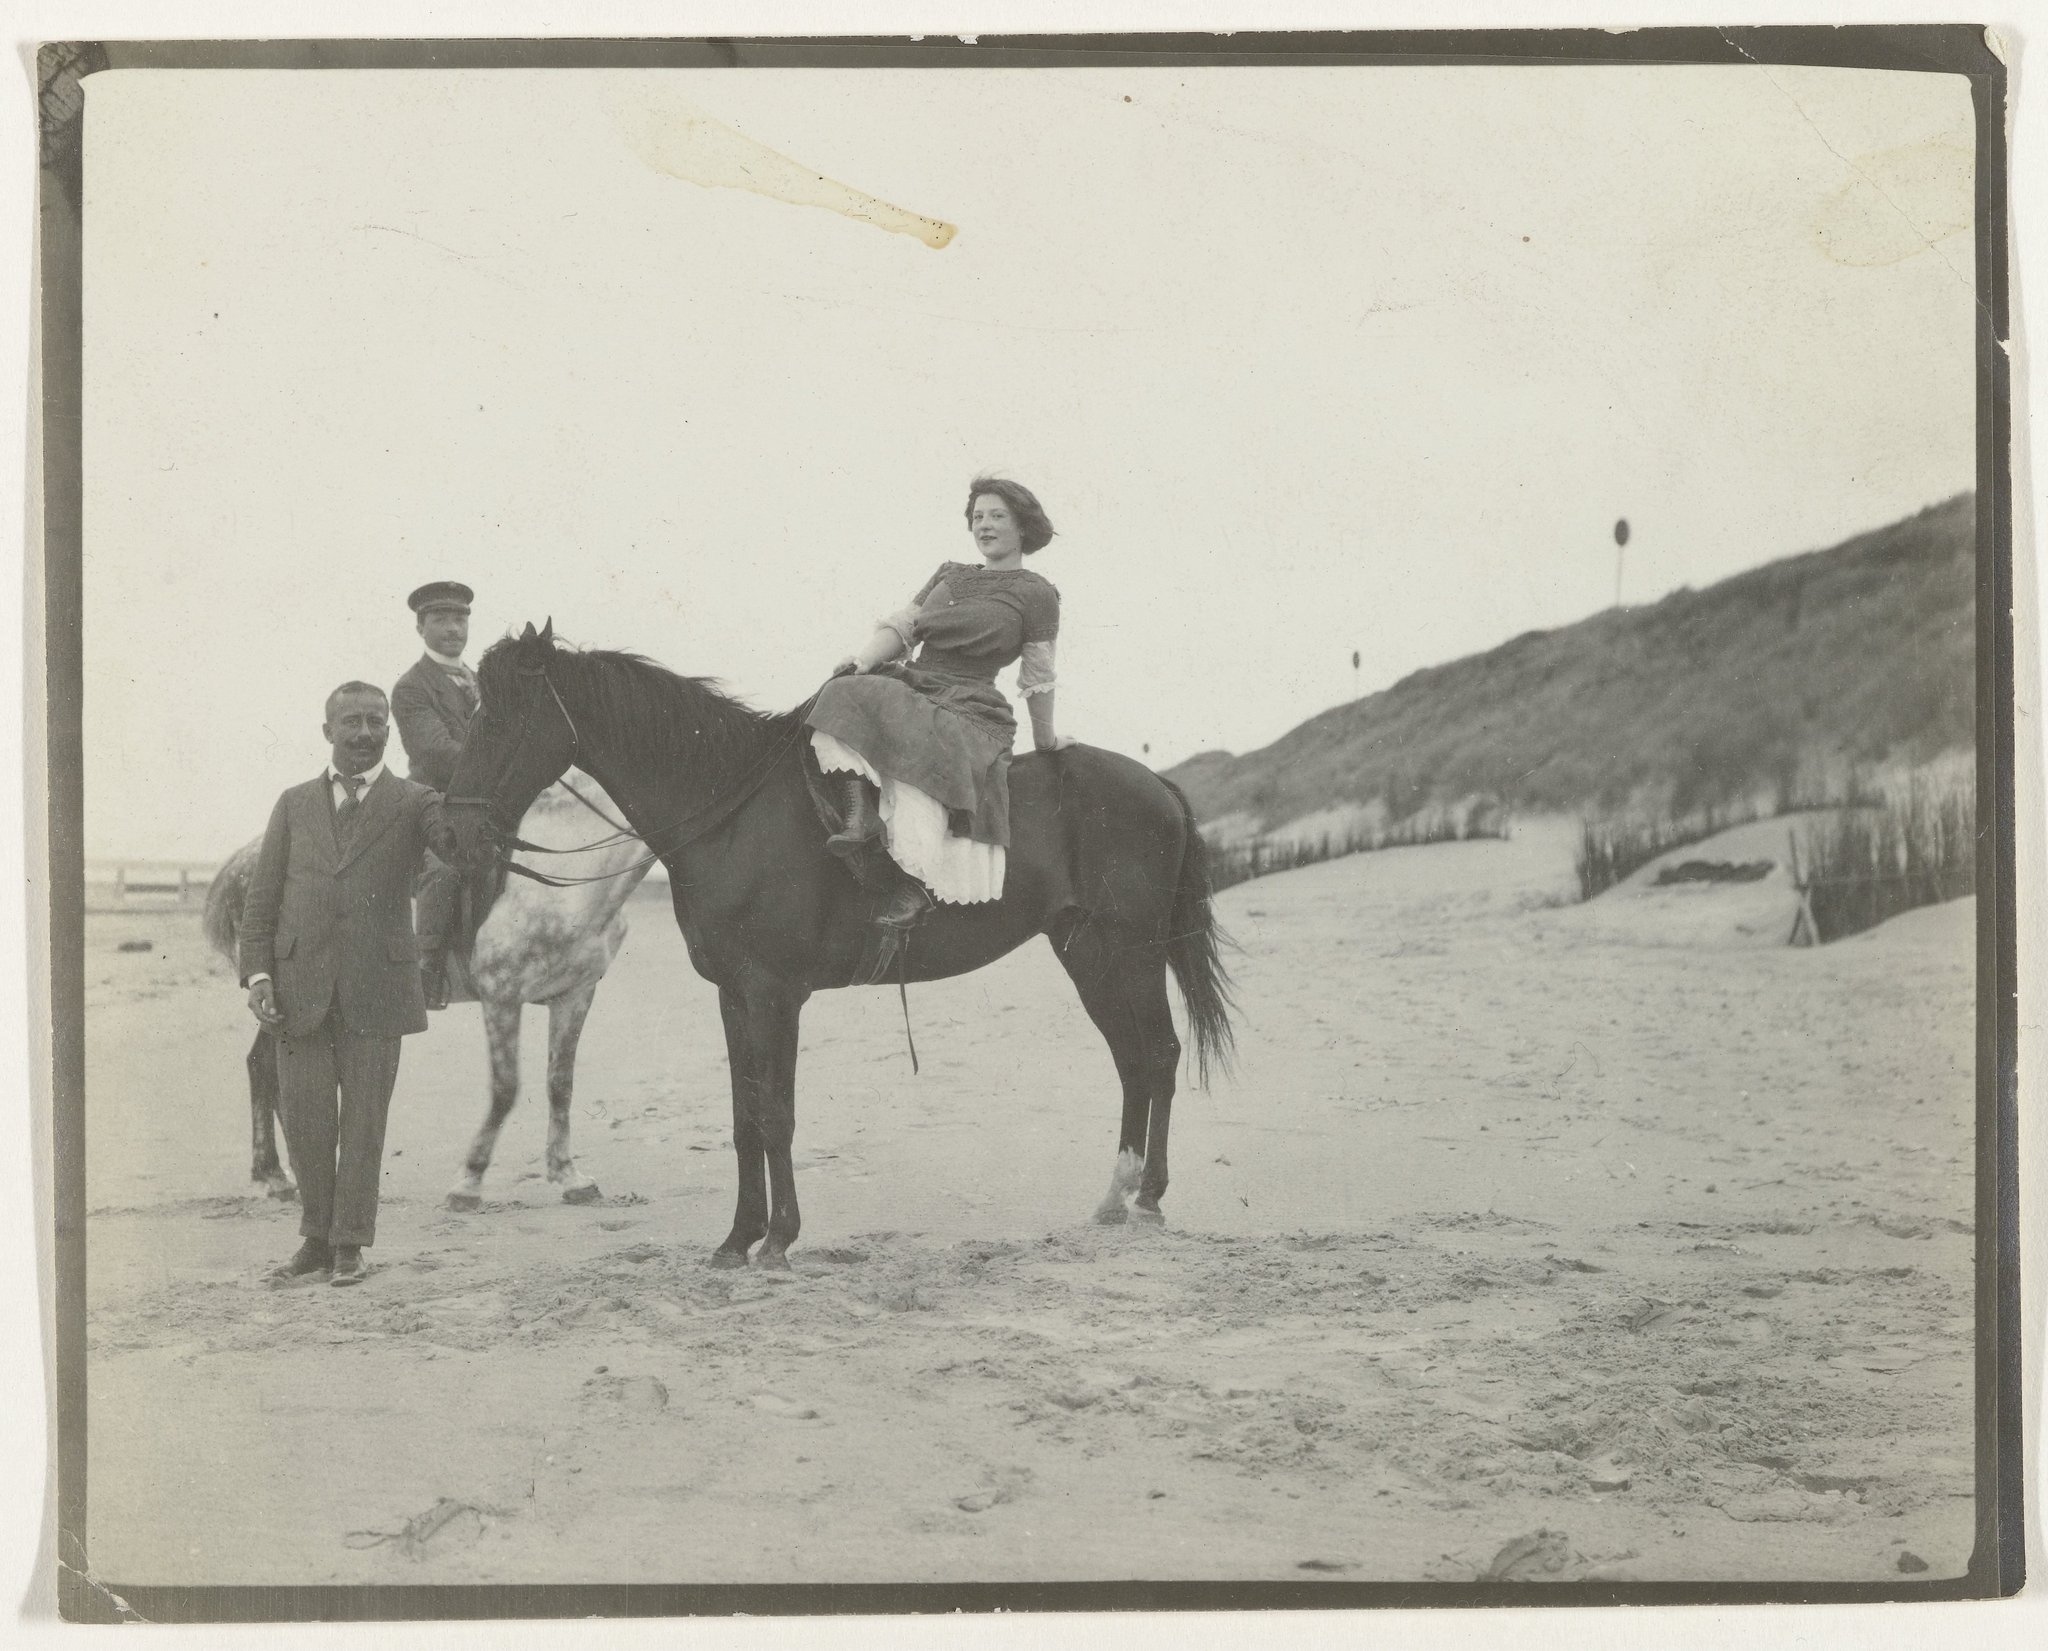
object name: photograph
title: Man en vrouw te paard op het strand (Noordzeekust), Nederland of Duitsland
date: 1900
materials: paper, photographic support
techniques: gelatin silver print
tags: beach (as place of recreation), riding a horse, ass, or mule; rider, horseman, netherlands, germany